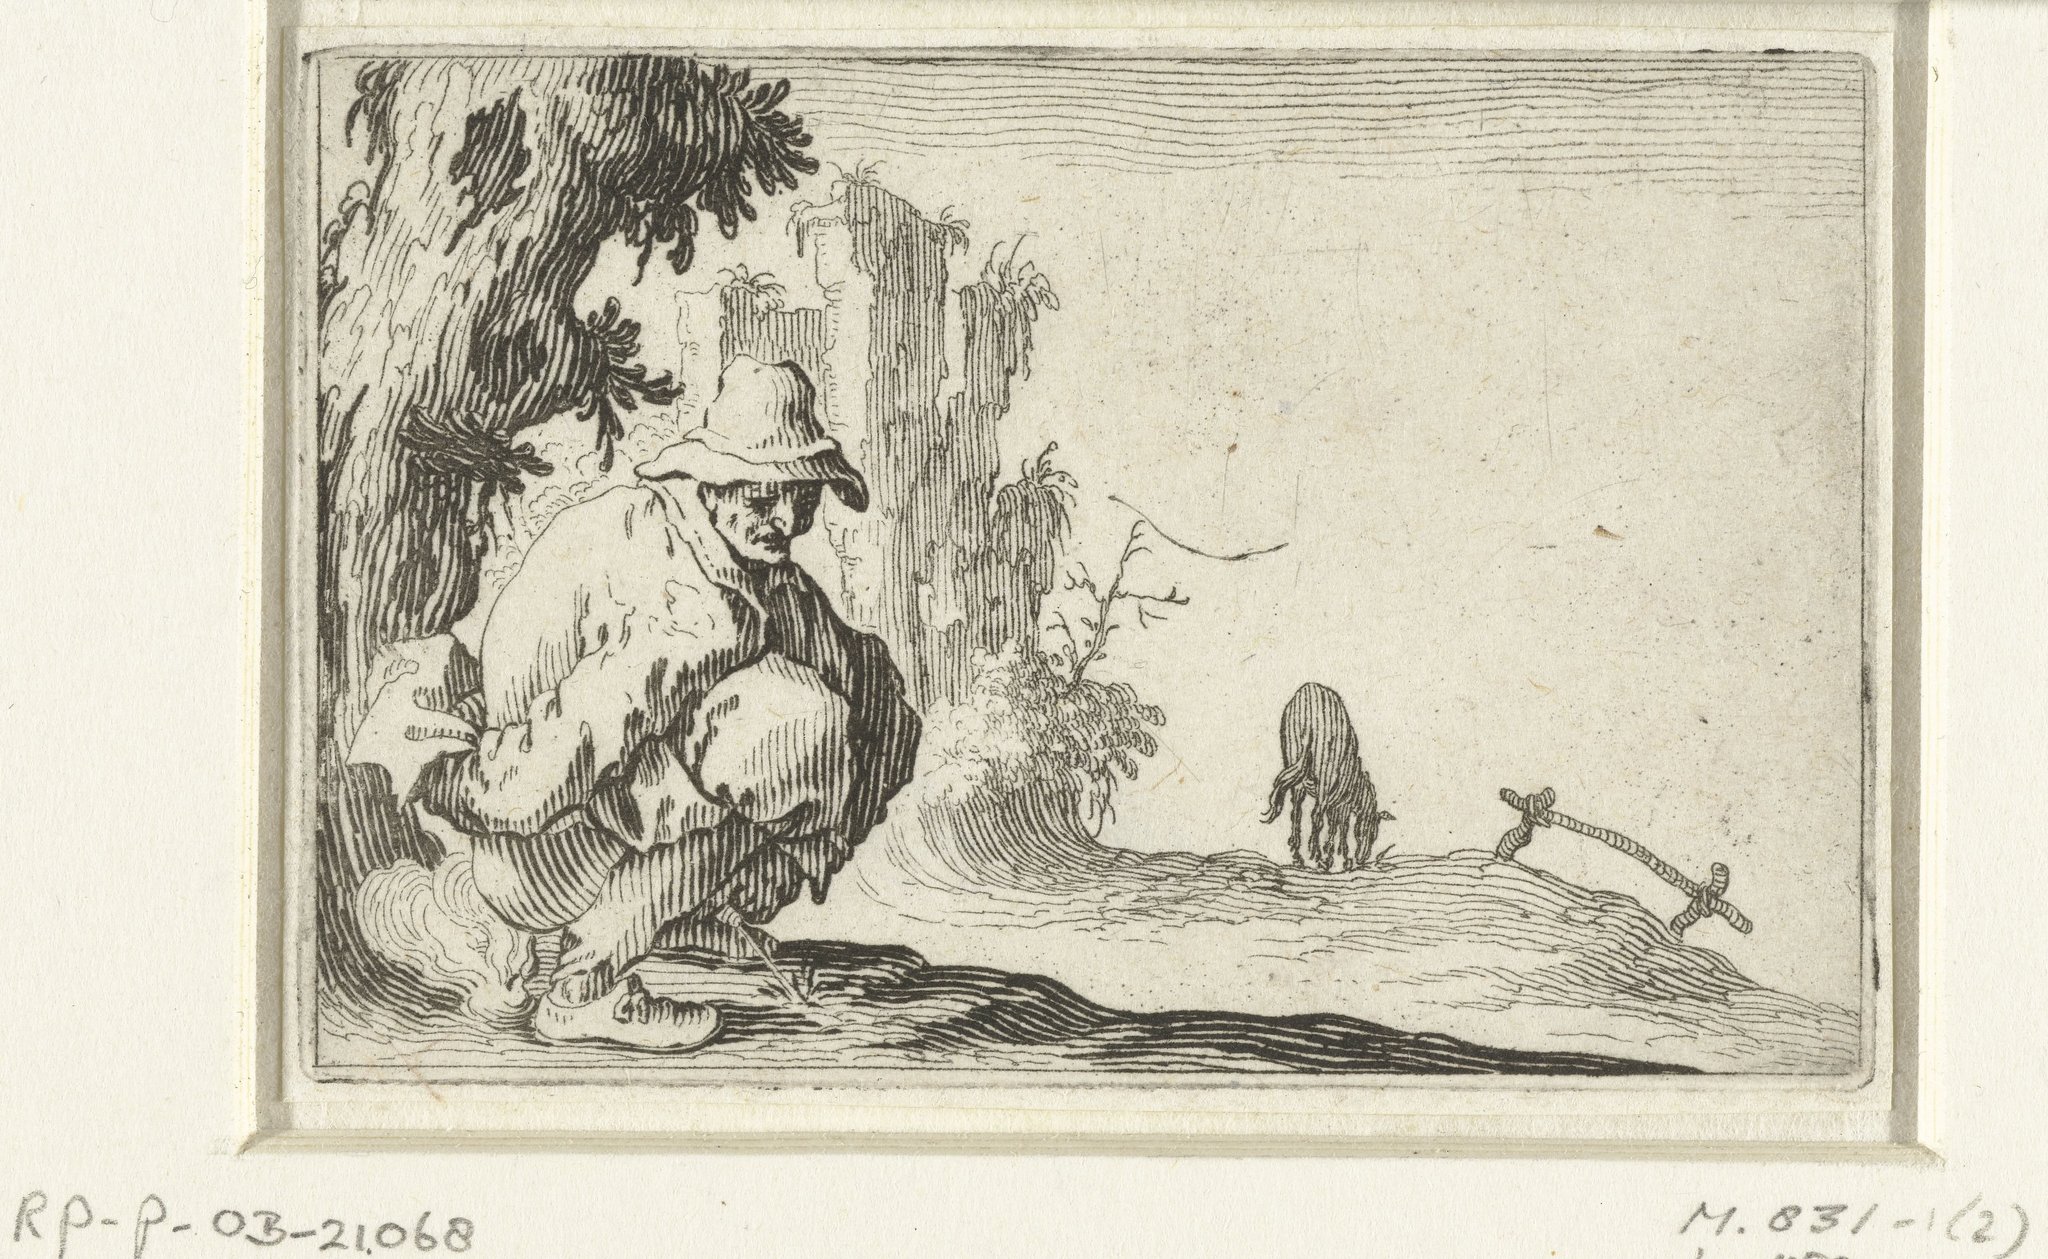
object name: print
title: Capricci di varie Figure di Jacopo Callot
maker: jacques callot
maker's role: draughtsman, print maker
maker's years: 1592-1635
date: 1621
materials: paper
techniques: etching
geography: nancy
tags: landscapes in the temperate zone, squatting, crouching figure, horse, urination, defecation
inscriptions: collector's mark: Lugt 240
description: Links op de voorgrond zit een man op zijn hurken zich te ontlasten. Op de achtergrond een grazend paard bij een hek. Deze prent is onderdeel van een serie van 48 prenten (50 incl. titelblad en dedicatieblad) met diverse onderwerpen (o.a. mannen en vrouwen in verschillende houdingen, landschappen, gebouwen en festiviteiten in Florence). Mogelijk zijn deze prenten bedoeld geweest als tekenvoorbeelden.